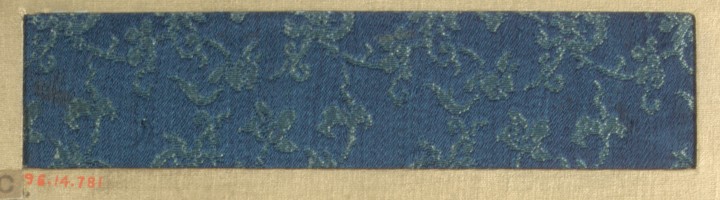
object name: piece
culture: japanese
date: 1701-1900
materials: silk